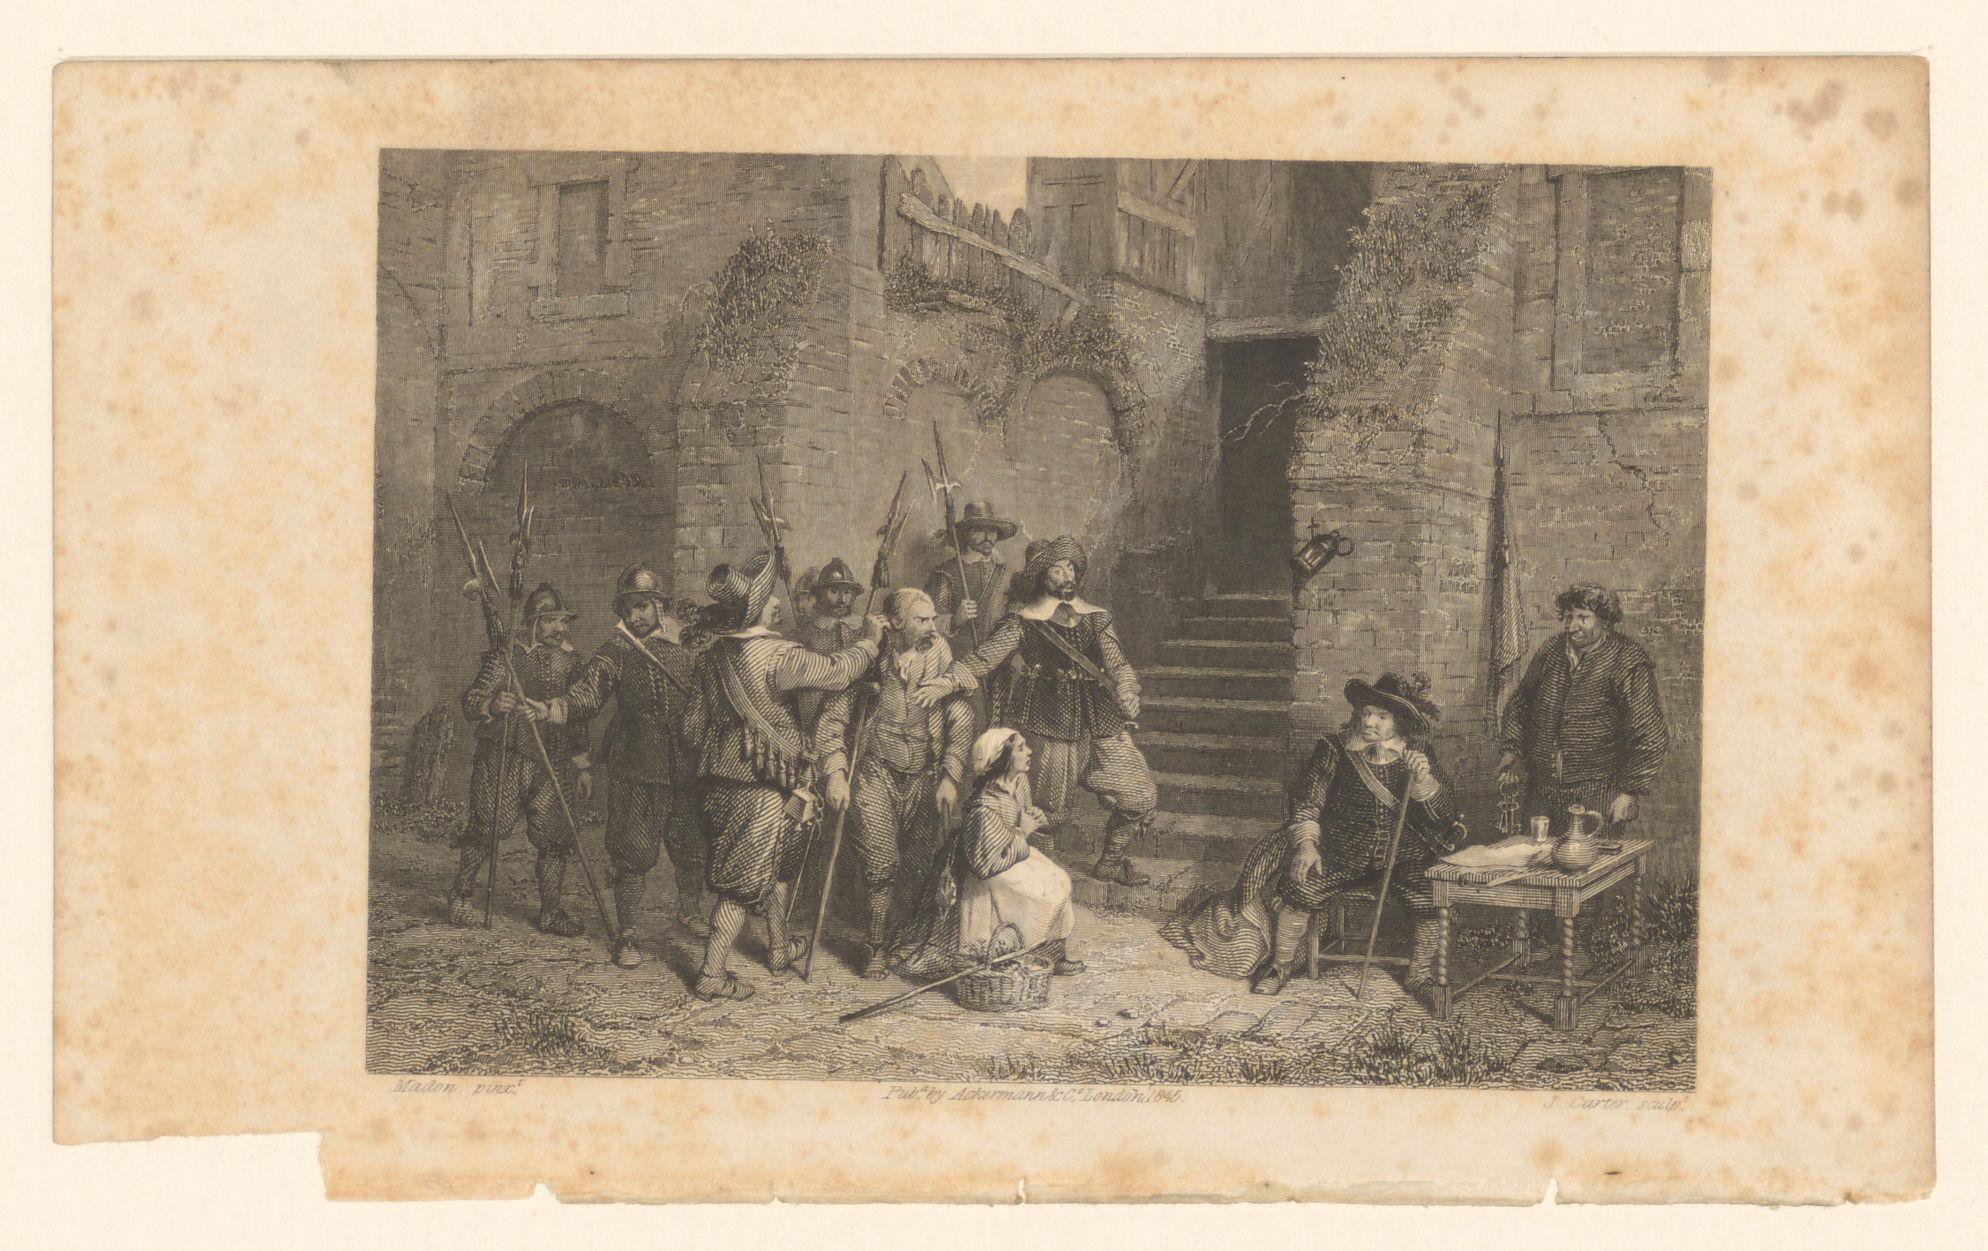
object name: print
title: Gewapende mannen houden een man vast terwijl een vrouw om genade smeekt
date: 1845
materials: paper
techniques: engraving, etching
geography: london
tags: prisoner of war (after the battle)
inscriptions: collector's mark: Lugt 2228